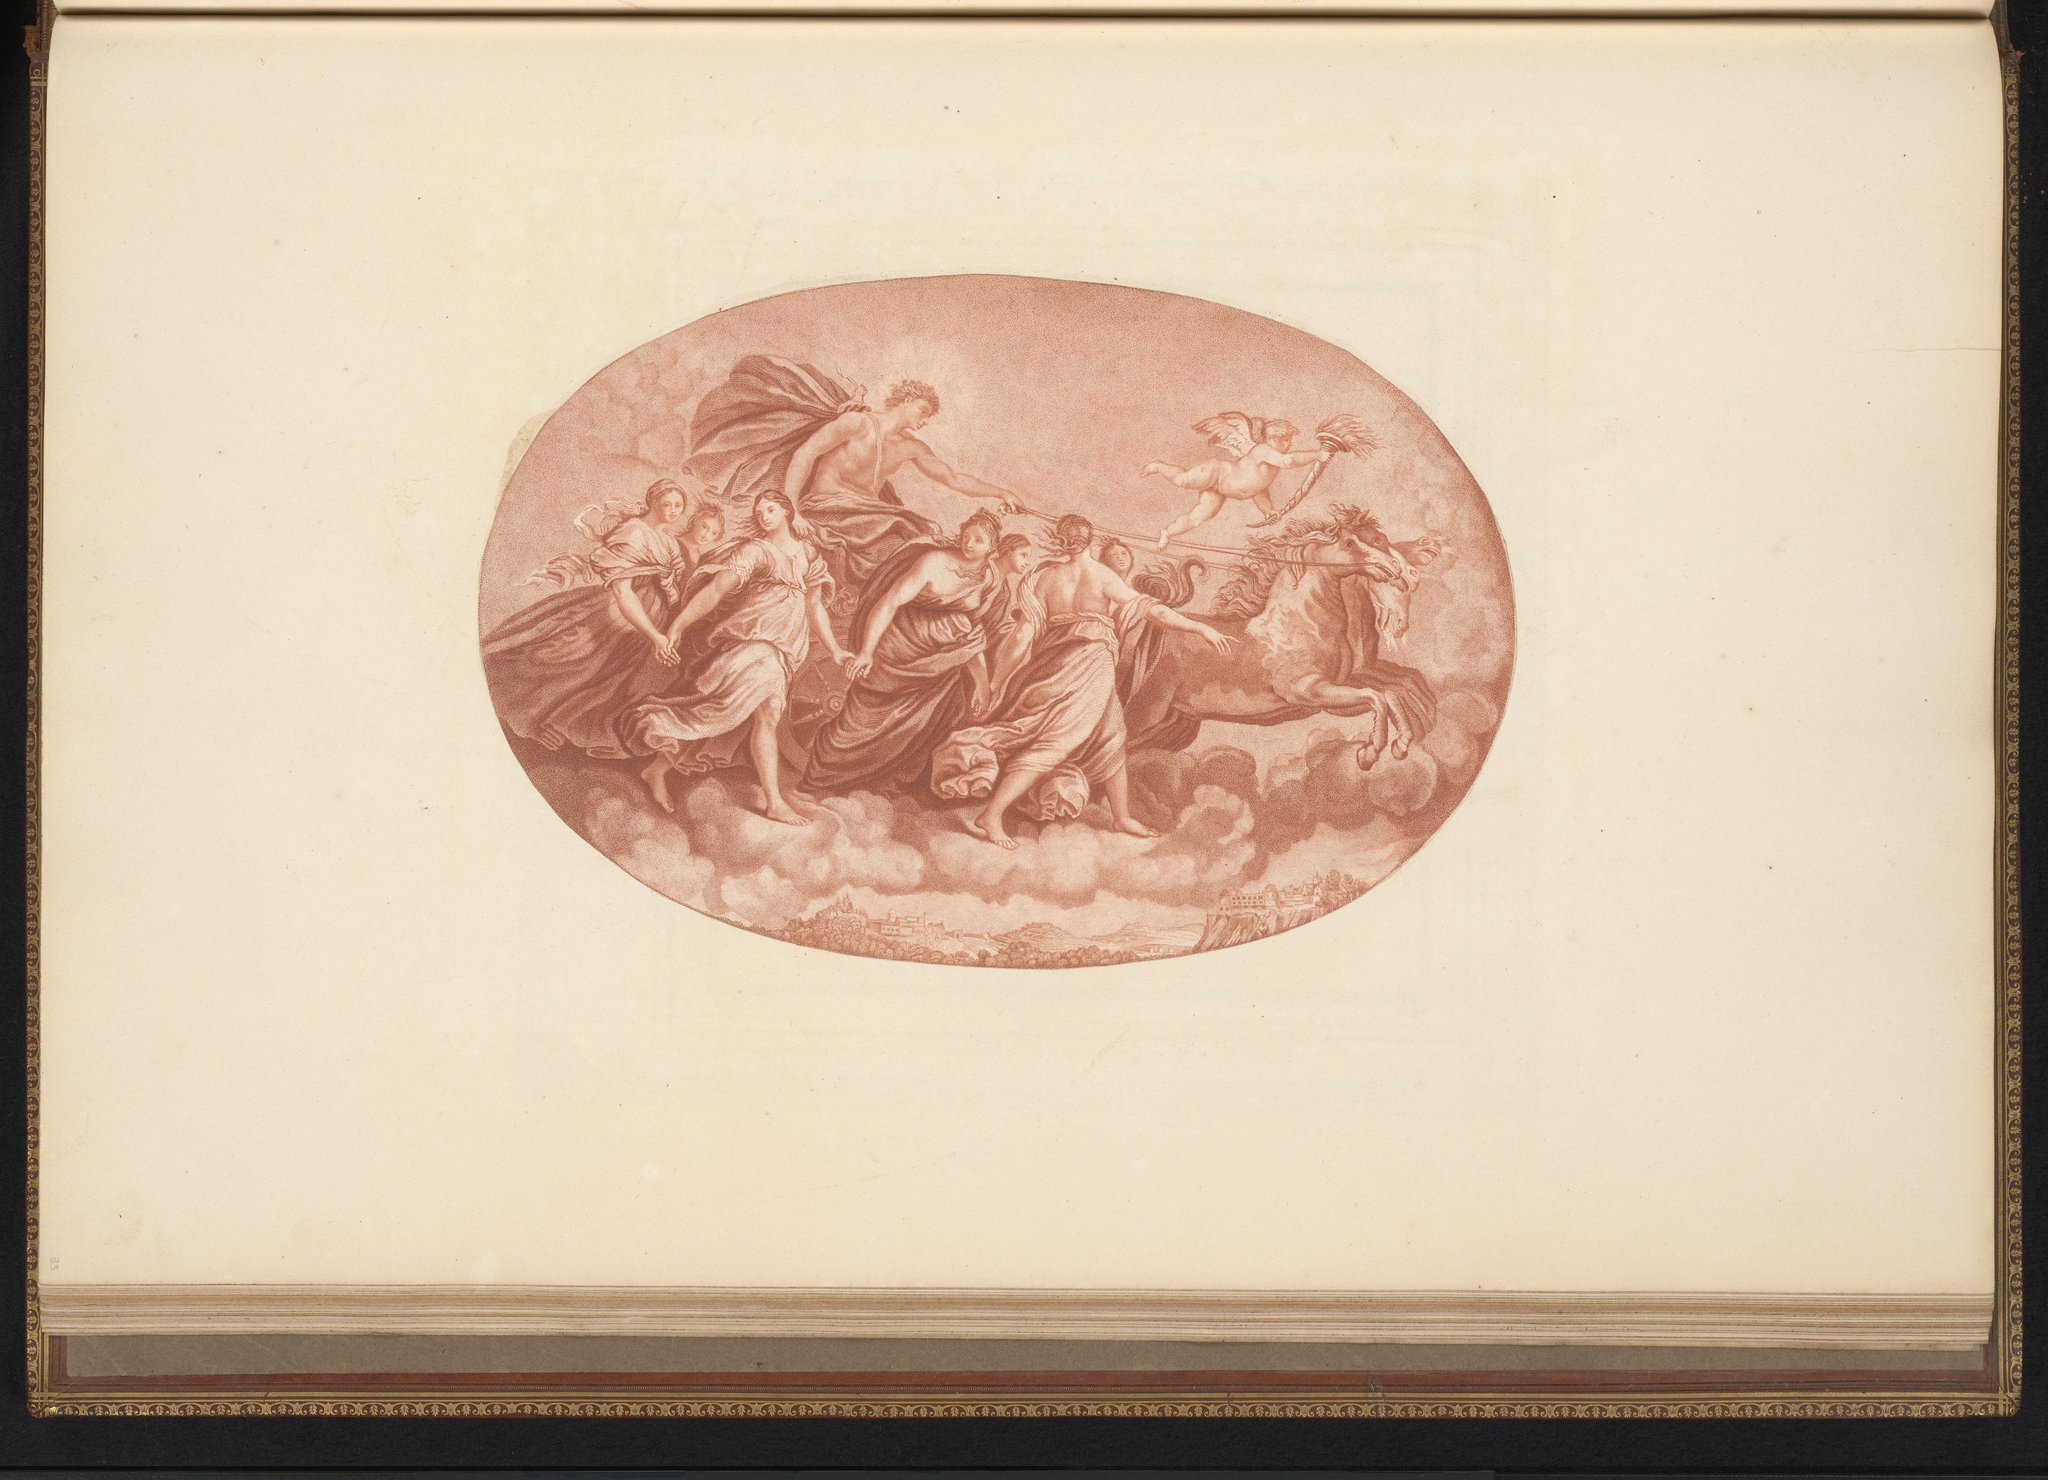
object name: print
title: Aurora leidt de wagen van Apollo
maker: william baillie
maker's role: print maker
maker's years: 1723-1810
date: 1753-1810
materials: paper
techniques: etching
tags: (story of) apollo (phoebus), apollo in the chariot of the sun, drawn by four horses, usually preceded by aurora holding a torch; 'carro del sole' (ripa), personification of the morning, 'aurora'; 'aurora' (ripa)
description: Apollo de Zonnegod zit op zijn wagen die vooruit wordt getrokken door vier paarden. Aurora wijst de weg. Voor de wagen zweeft een putto met een fakkel. De prent maakt deel uit van een album.